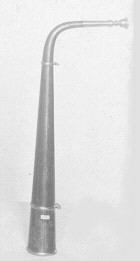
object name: ohotniche rogie sounding b flat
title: Ohotniche Rogie sounding B-flat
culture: russian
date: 1834-1866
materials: copper, nickel, silver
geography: russia